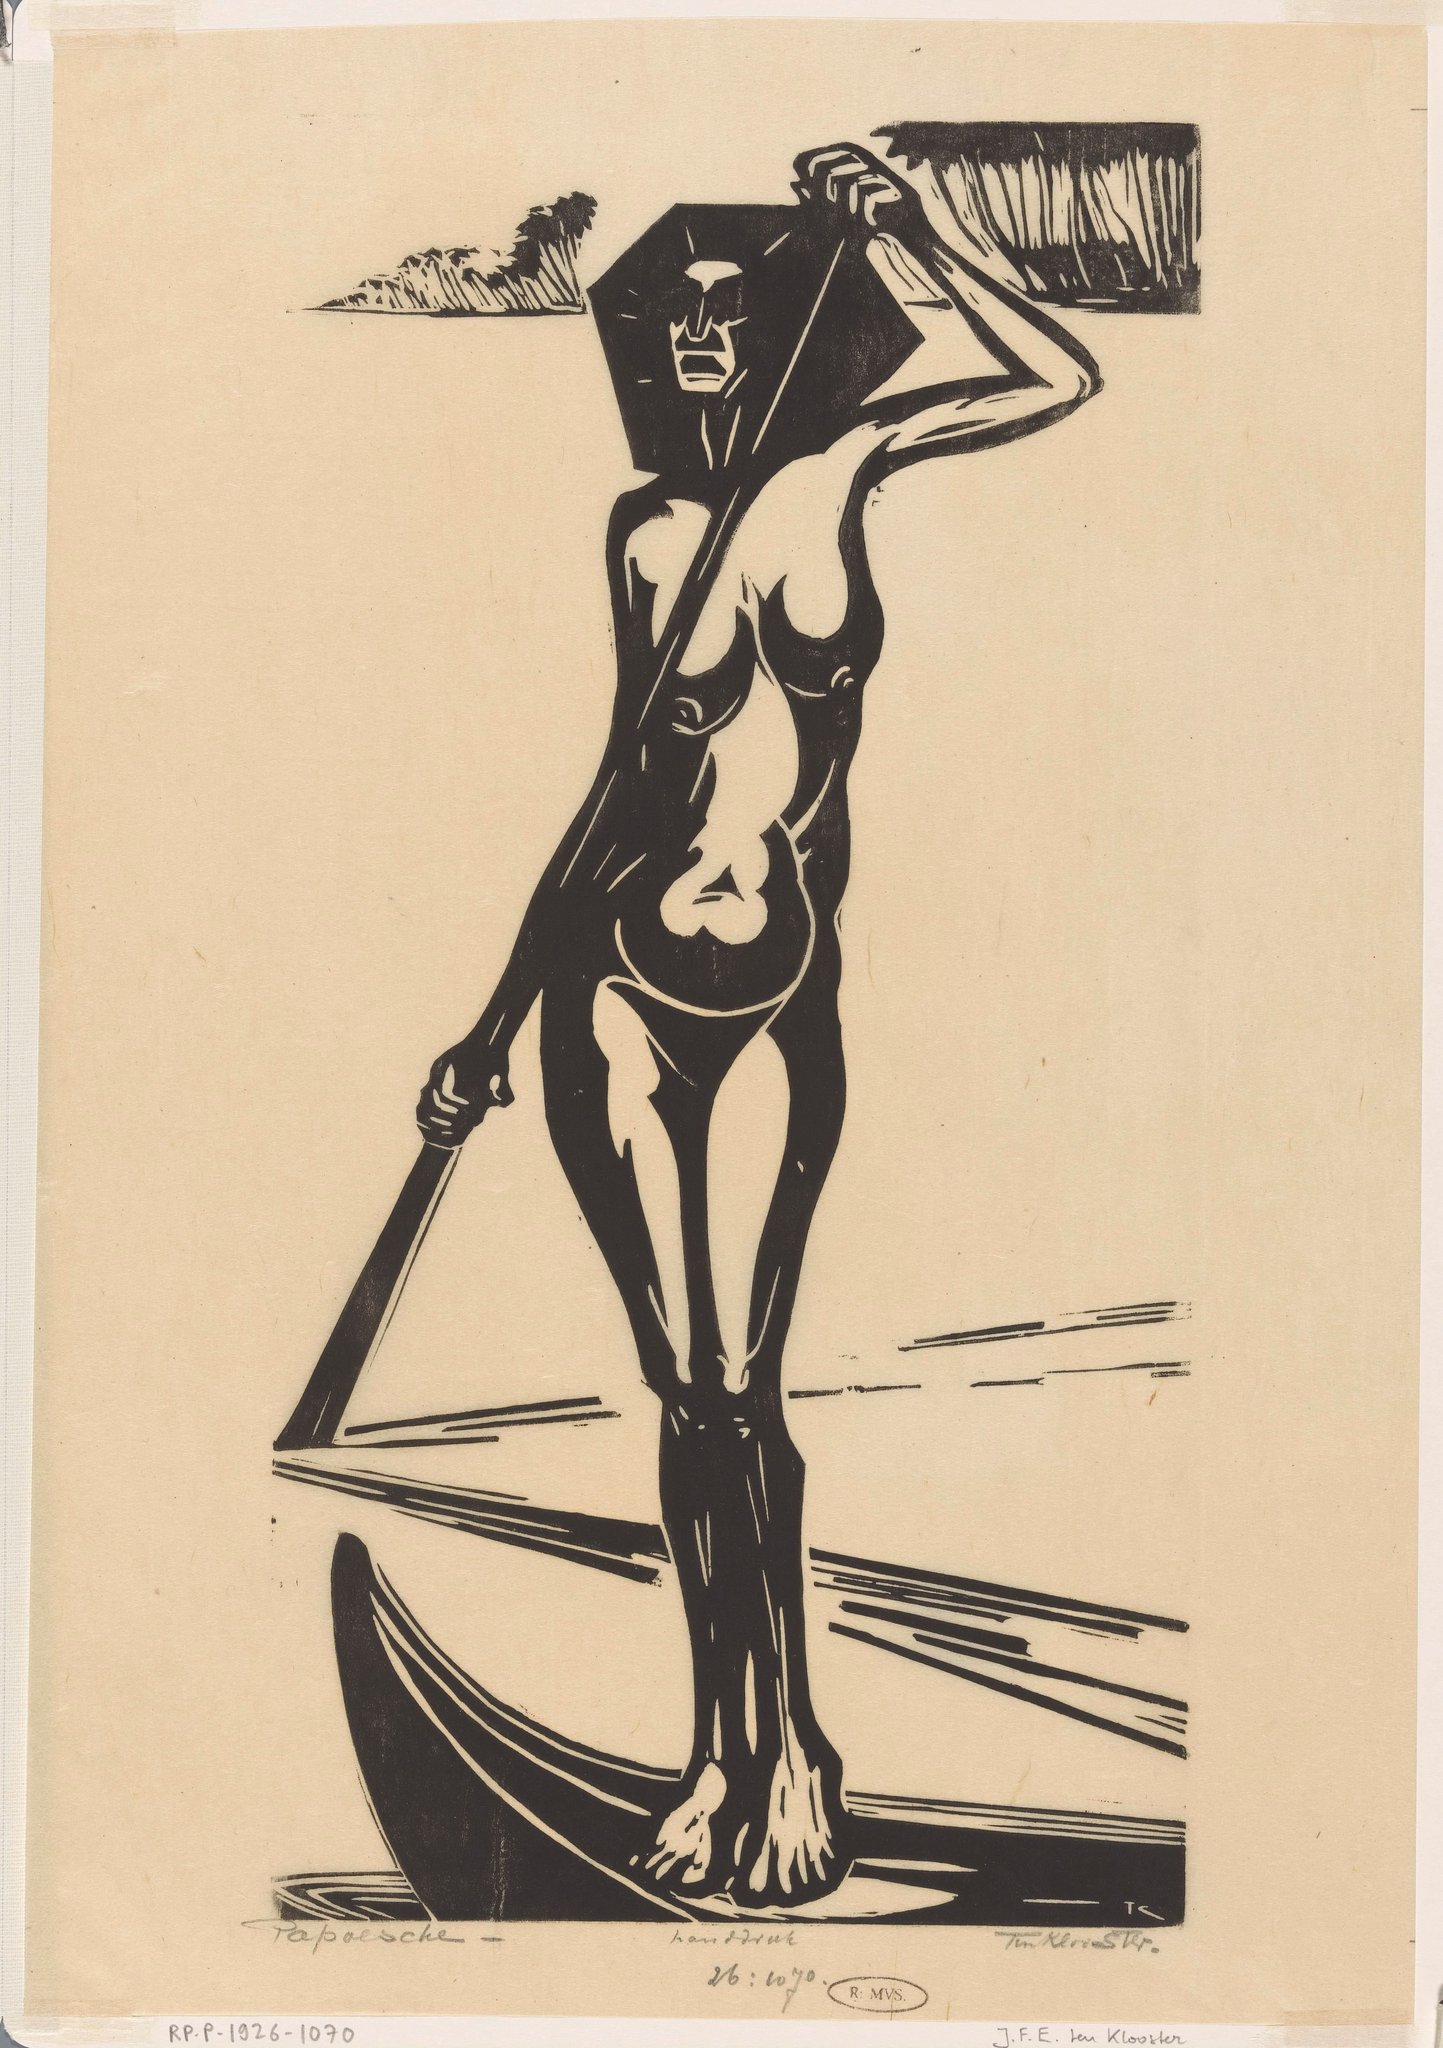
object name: print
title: Papoesche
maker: johannes frederik engelbert ten klooster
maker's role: draughtsman, print maker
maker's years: 1873-1940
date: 1925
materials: paper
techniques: woodcut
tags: woman (showing herself) undressed, quasi-nude, rowing-boat, canoe, etc., standing figure - aa - female human figure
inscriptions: collector's mark: Lugt 2228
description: Een naakte vrouw, staand in een kano met een roeispaan in haar handen.